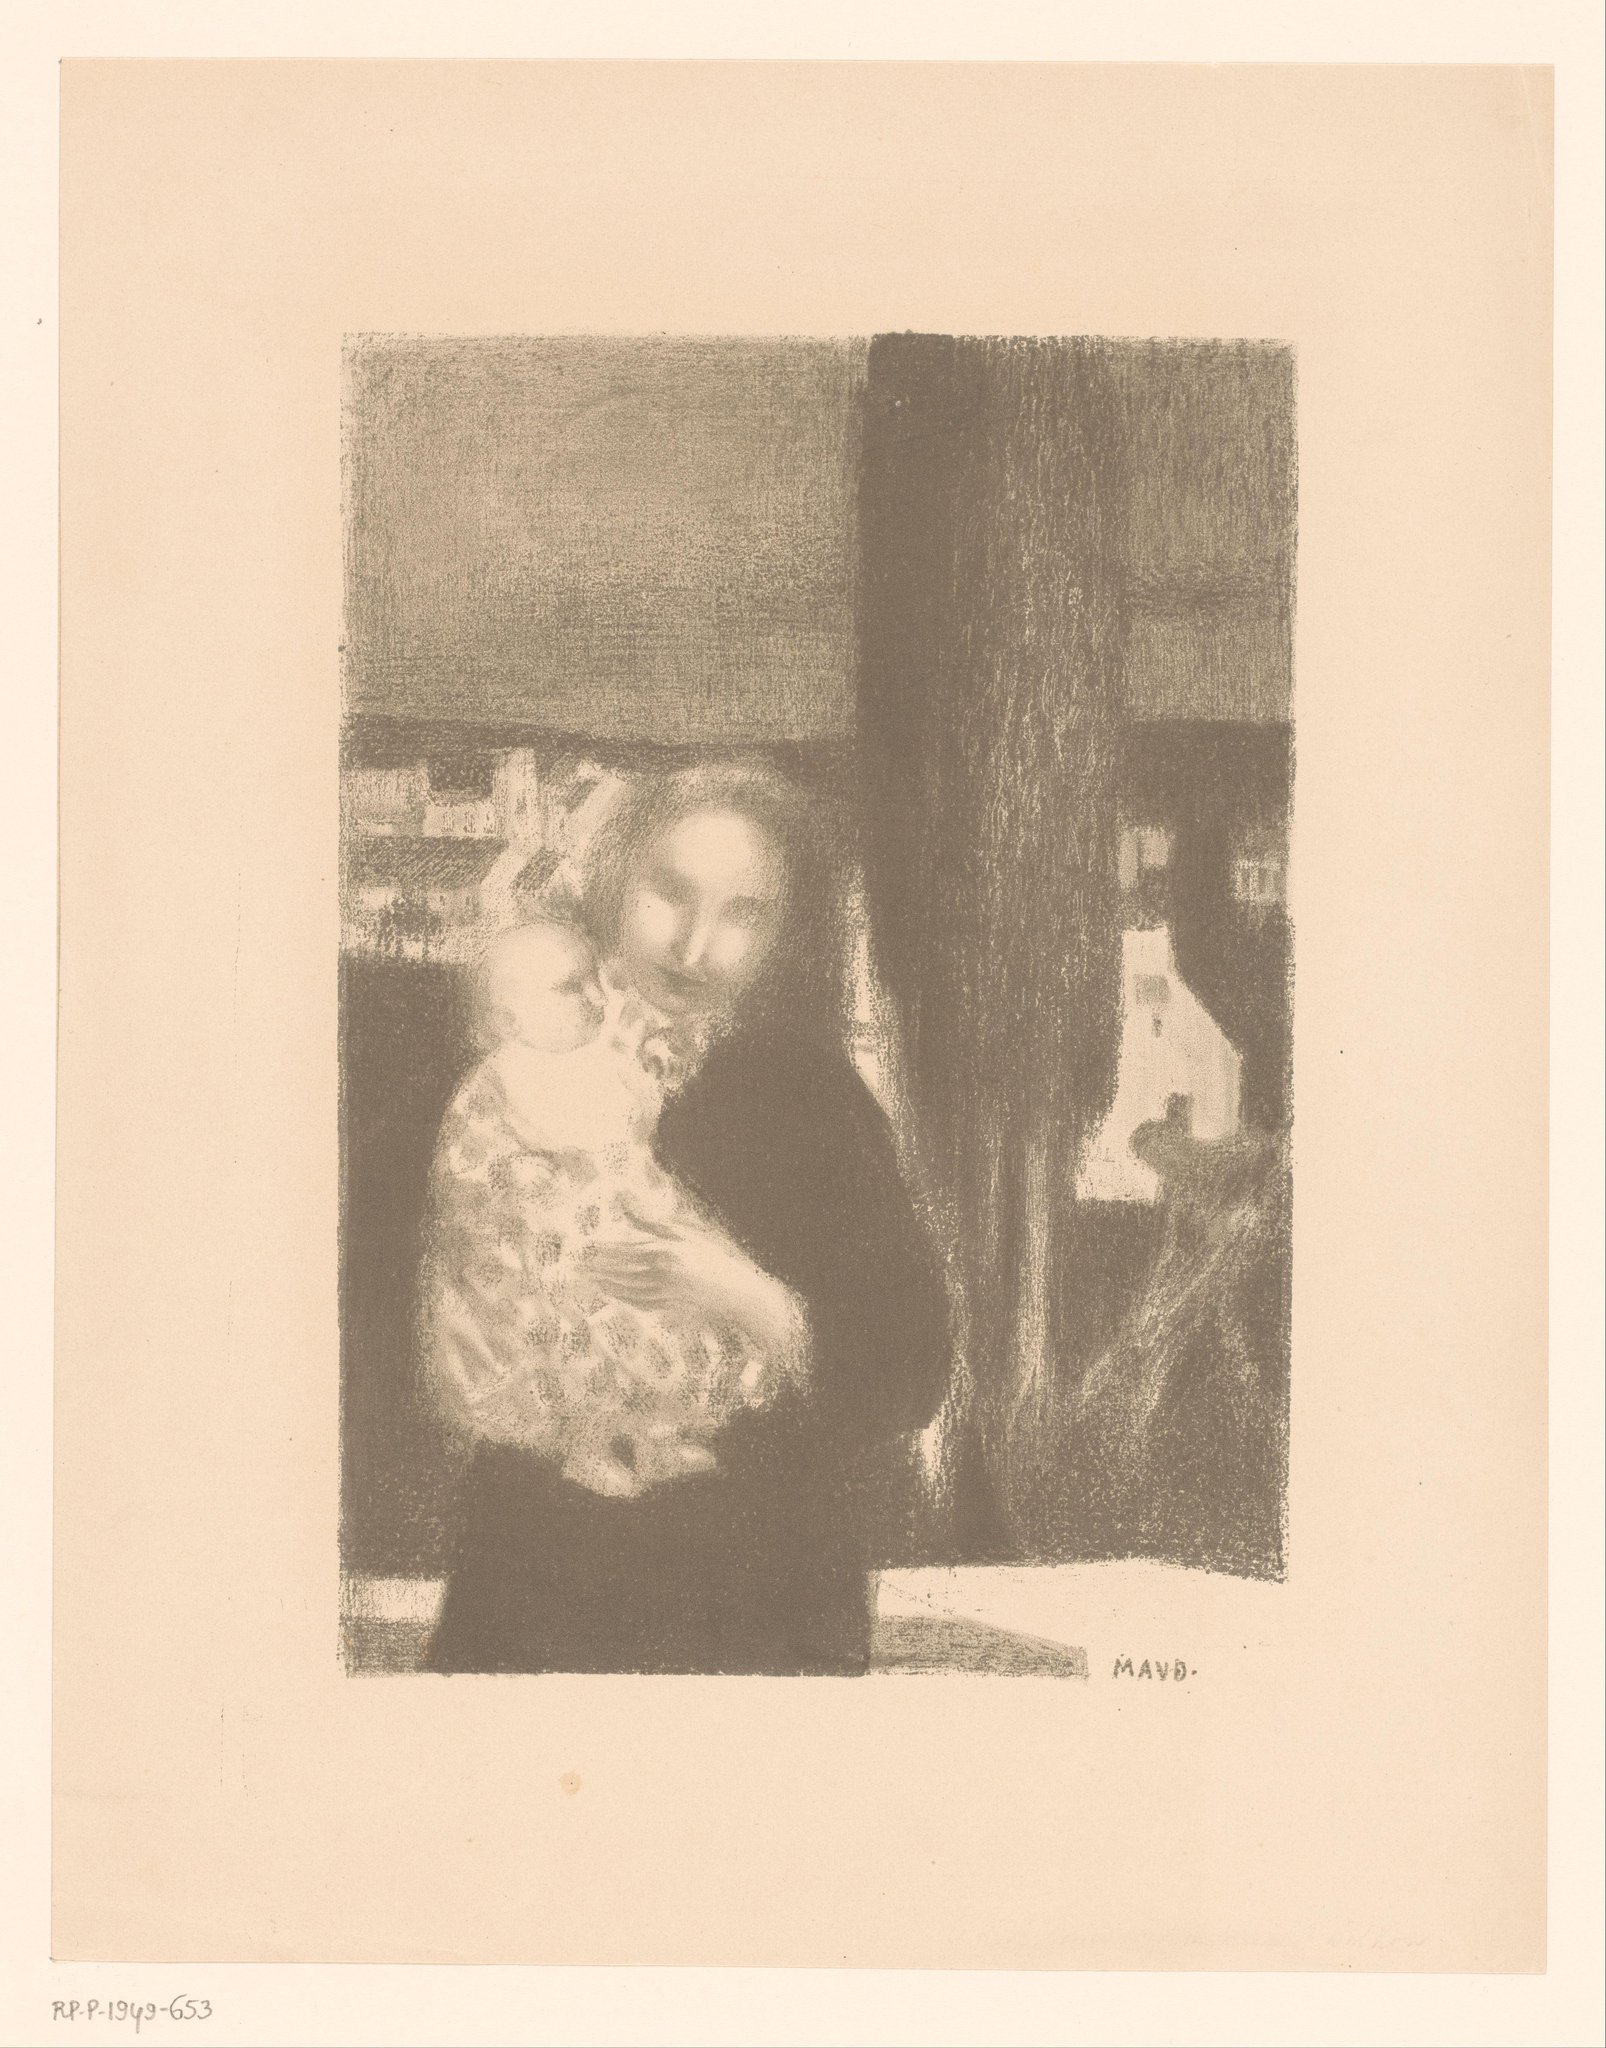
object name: print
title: La jeune mère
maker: maurice denis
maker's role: print maker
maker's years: 1870-1943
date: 1898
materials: paper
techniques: lithography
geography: paris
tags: trees: cypress, mother and baby or young child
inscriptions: collector's mark: Lugt 2228a, collector's mark: Lugt 2760